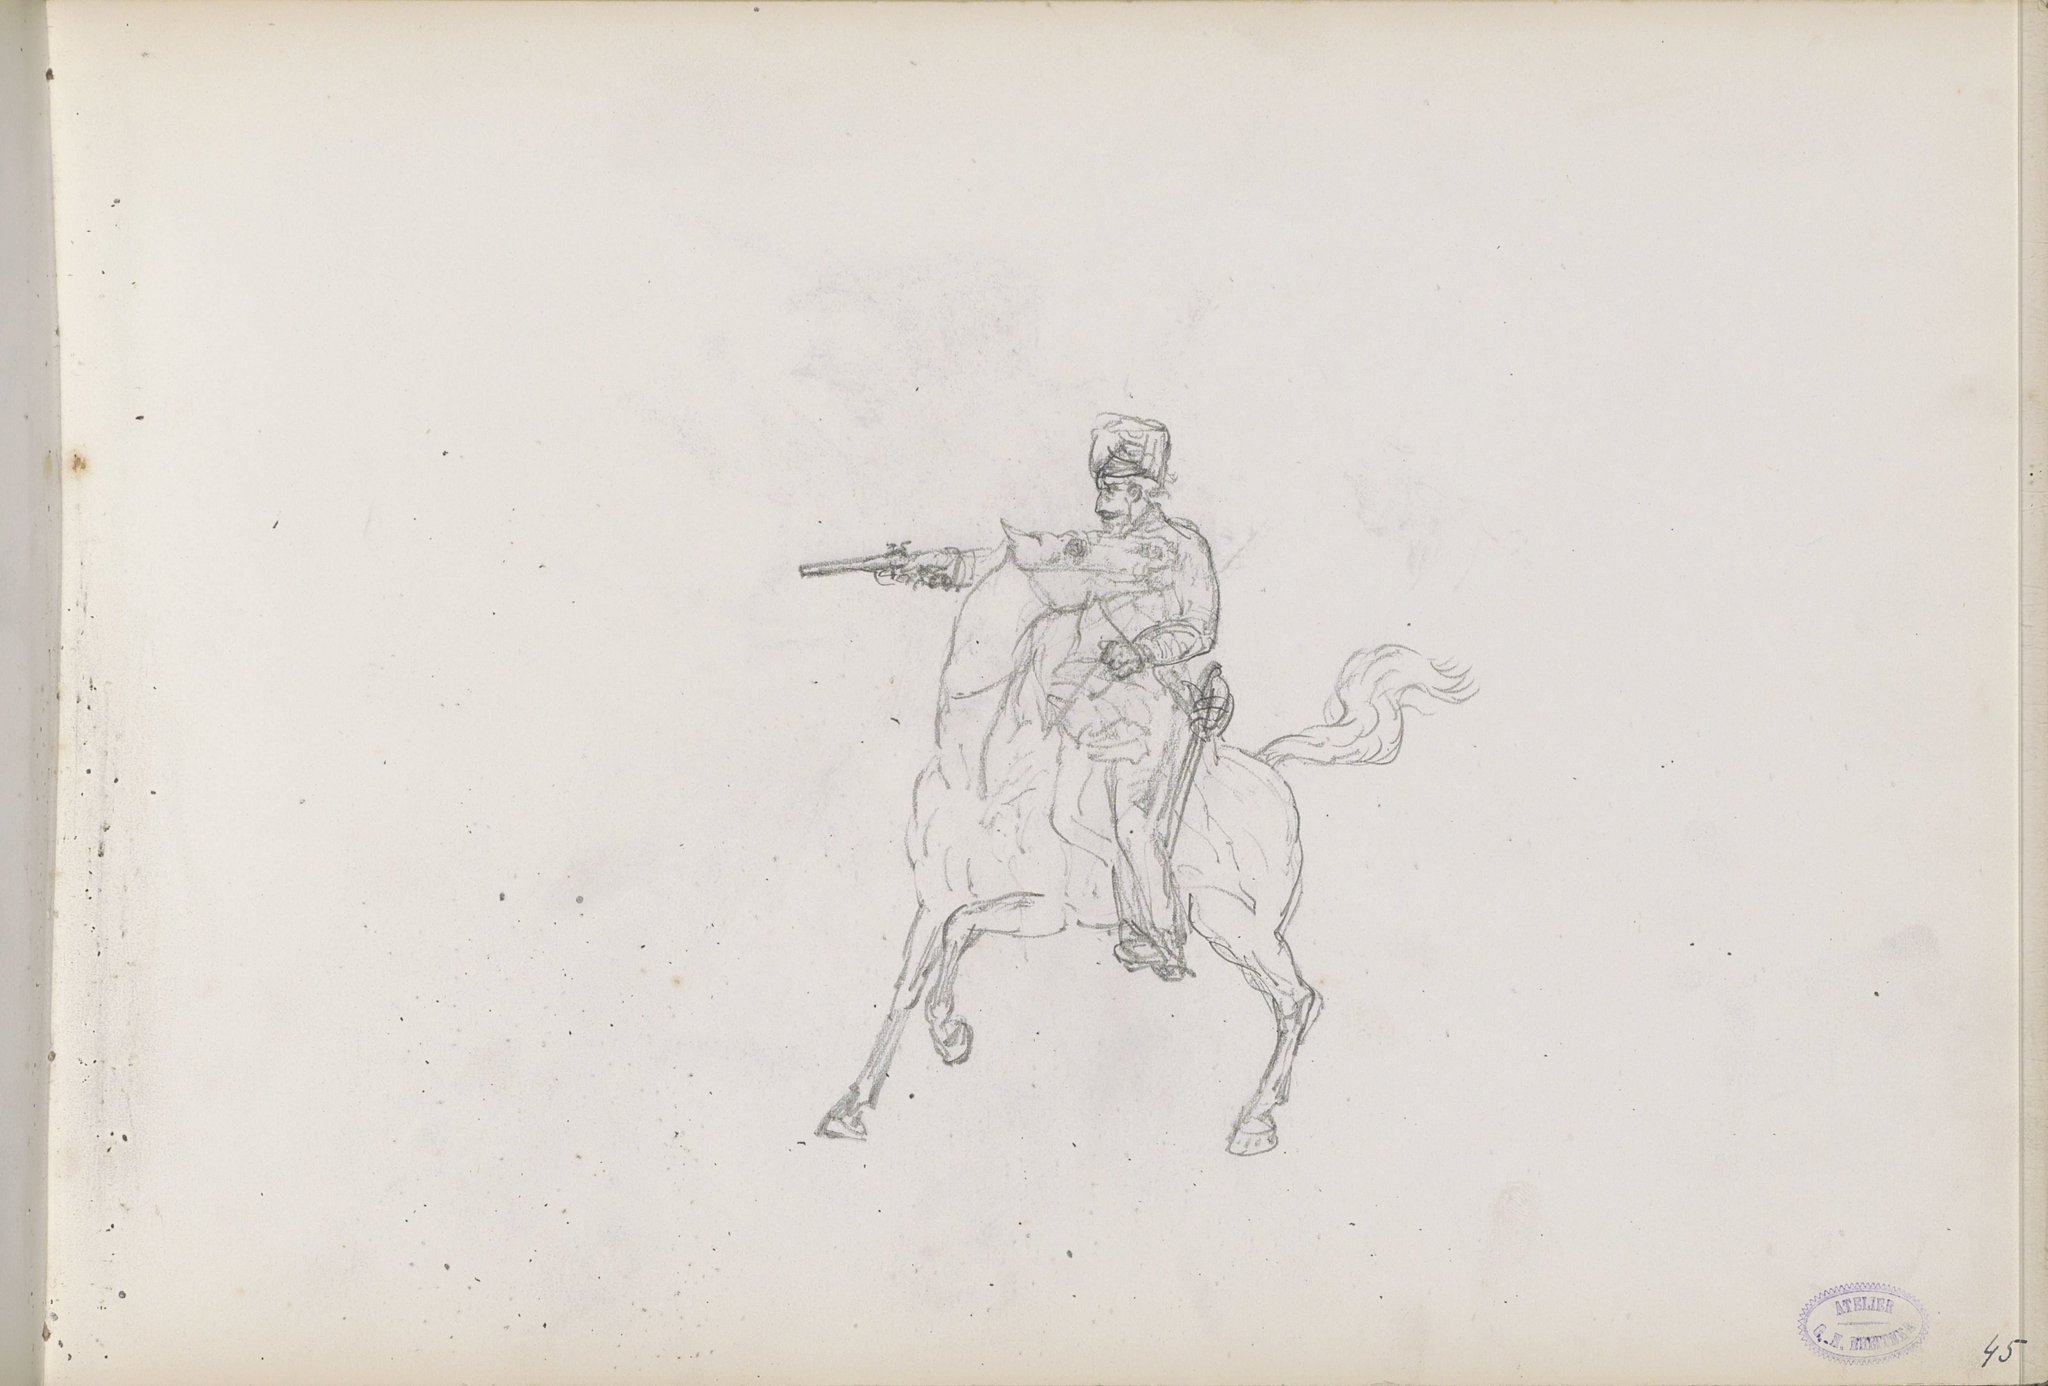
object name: sketchbook leaf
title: Soldaat met een vuurwapen te paard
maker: george hendrik breitner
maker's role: draughtsman, painter, print maker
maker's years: 1857-1923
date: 1873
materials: paper, pencil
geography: rotterdam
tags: division of armed forces (+ cavalry, horsemen), firearms, horse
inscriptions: workshop stamp: Lugt 291d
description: Blad 45 recto uit een schetsboek met 25 bladen.